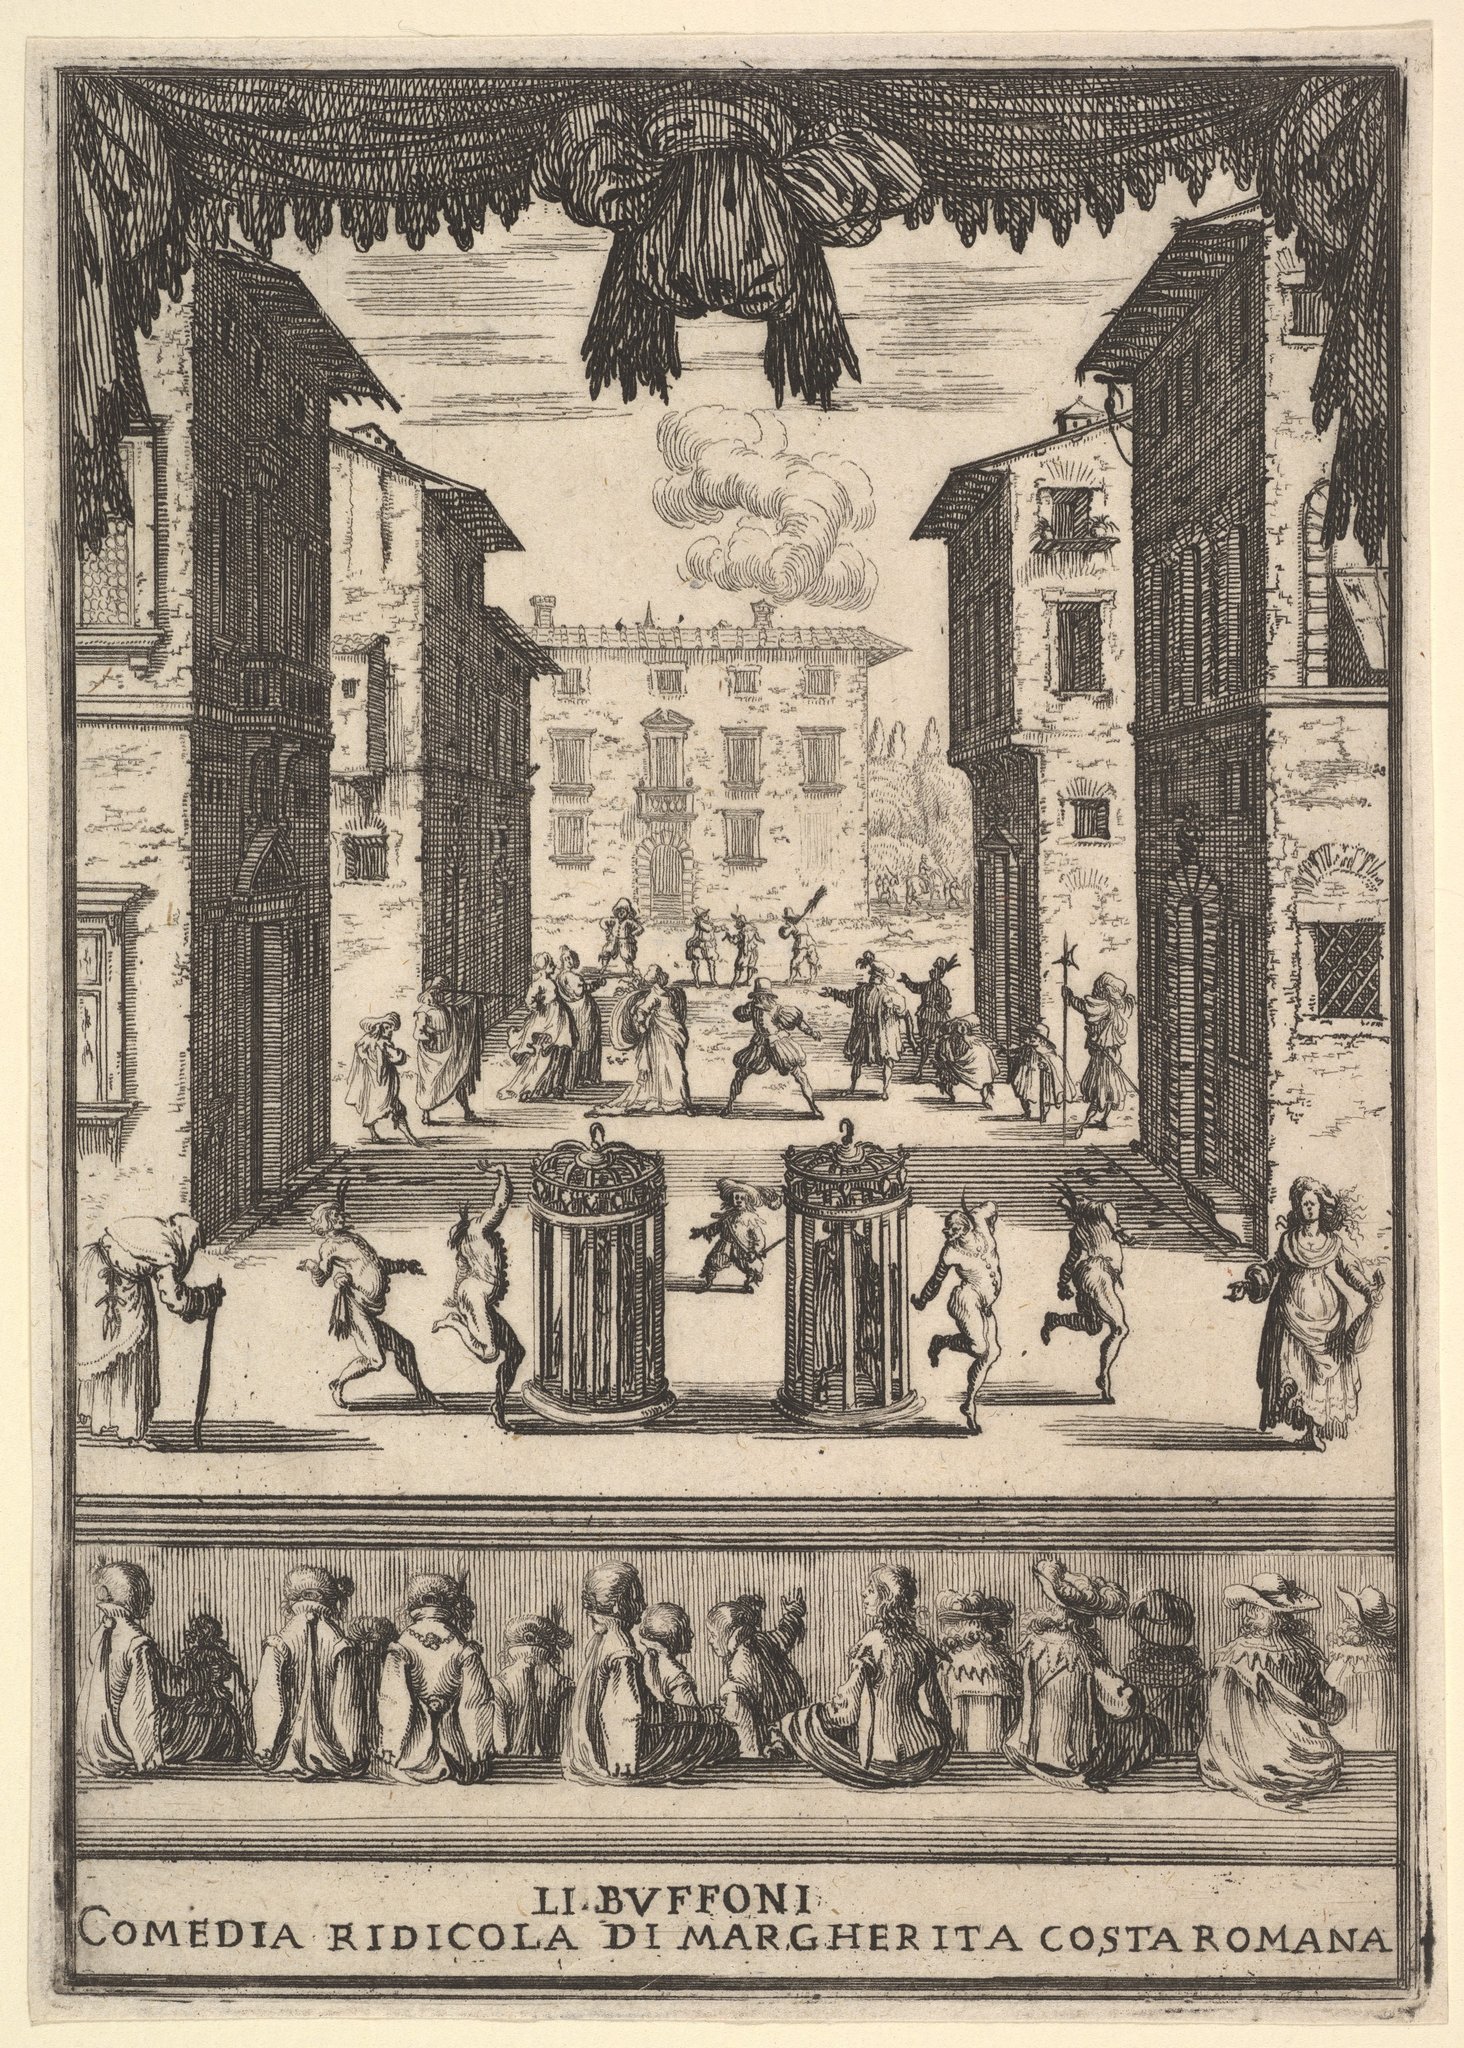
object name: print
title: Frontispiece for the comedy "The Buffoons" (Li Buffoni)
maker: stefano della bella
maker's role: artist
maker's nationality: italian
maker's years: 1610-1664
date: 1639-1641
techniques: etching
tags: dancing